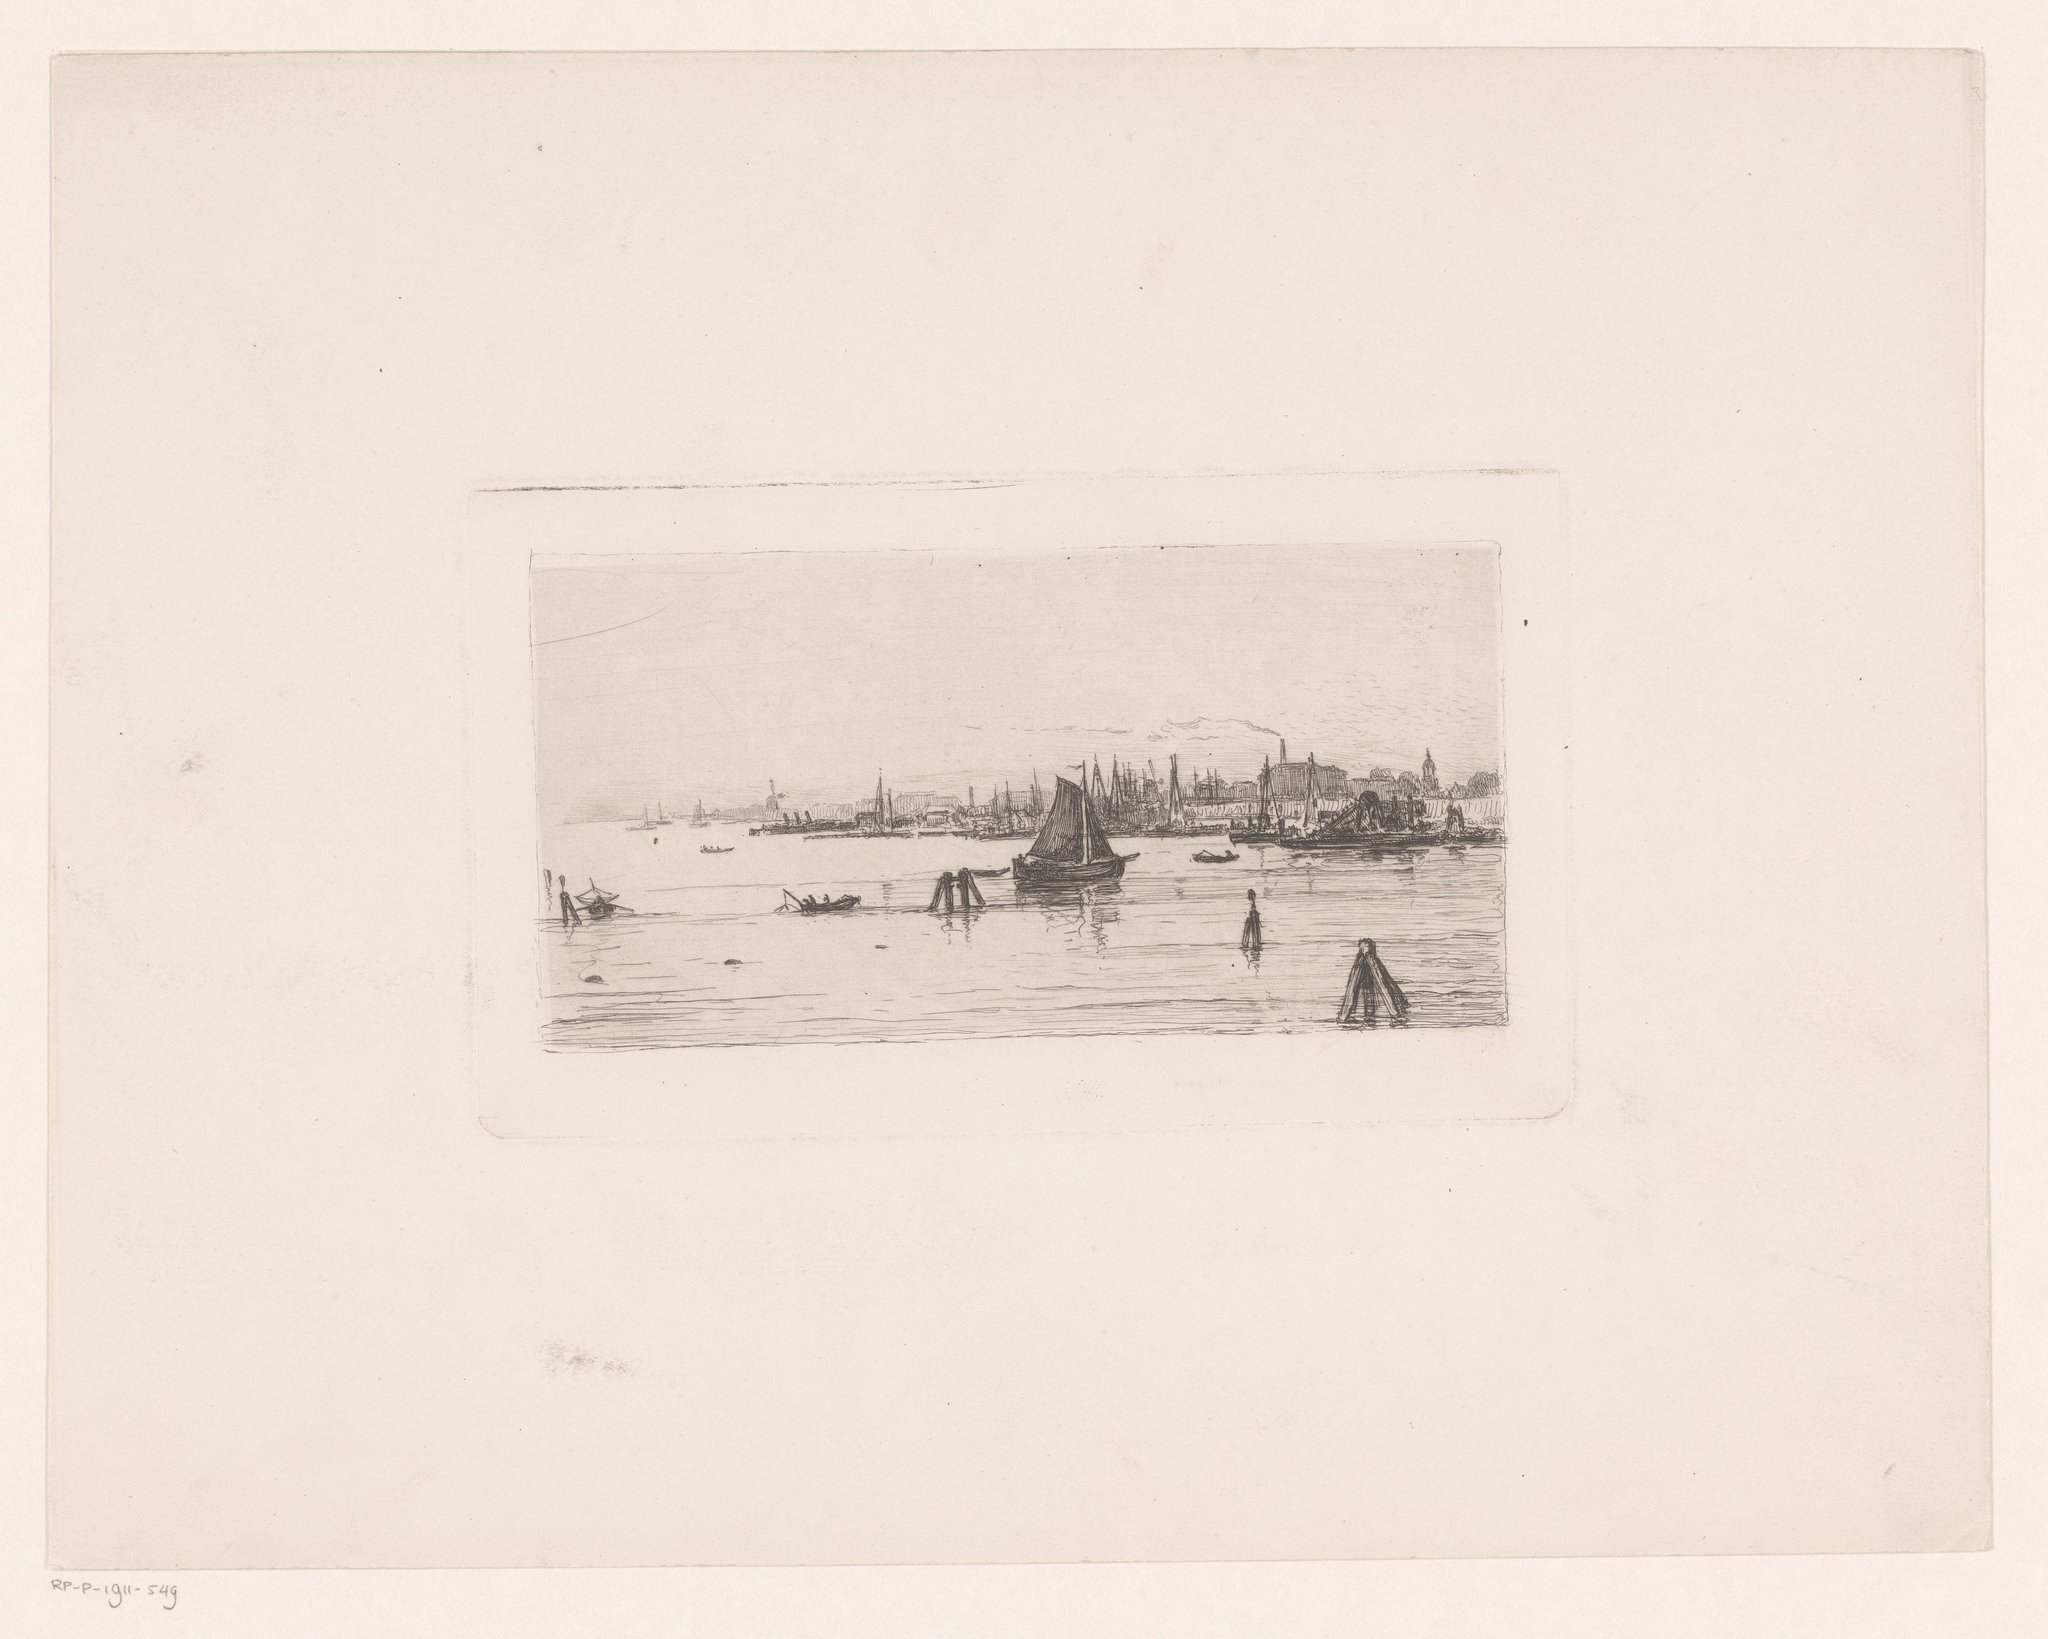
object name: print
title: Gezicht op Amsterdam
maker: william unger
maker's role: draughtsman, painter, print maker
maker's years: 1837-1932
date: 1874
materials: paper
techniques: etching, intaglio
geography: germany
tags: harbour, sailing-ship, sailing-boat, amsterdam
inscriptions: collector's mark: Lugt 2228